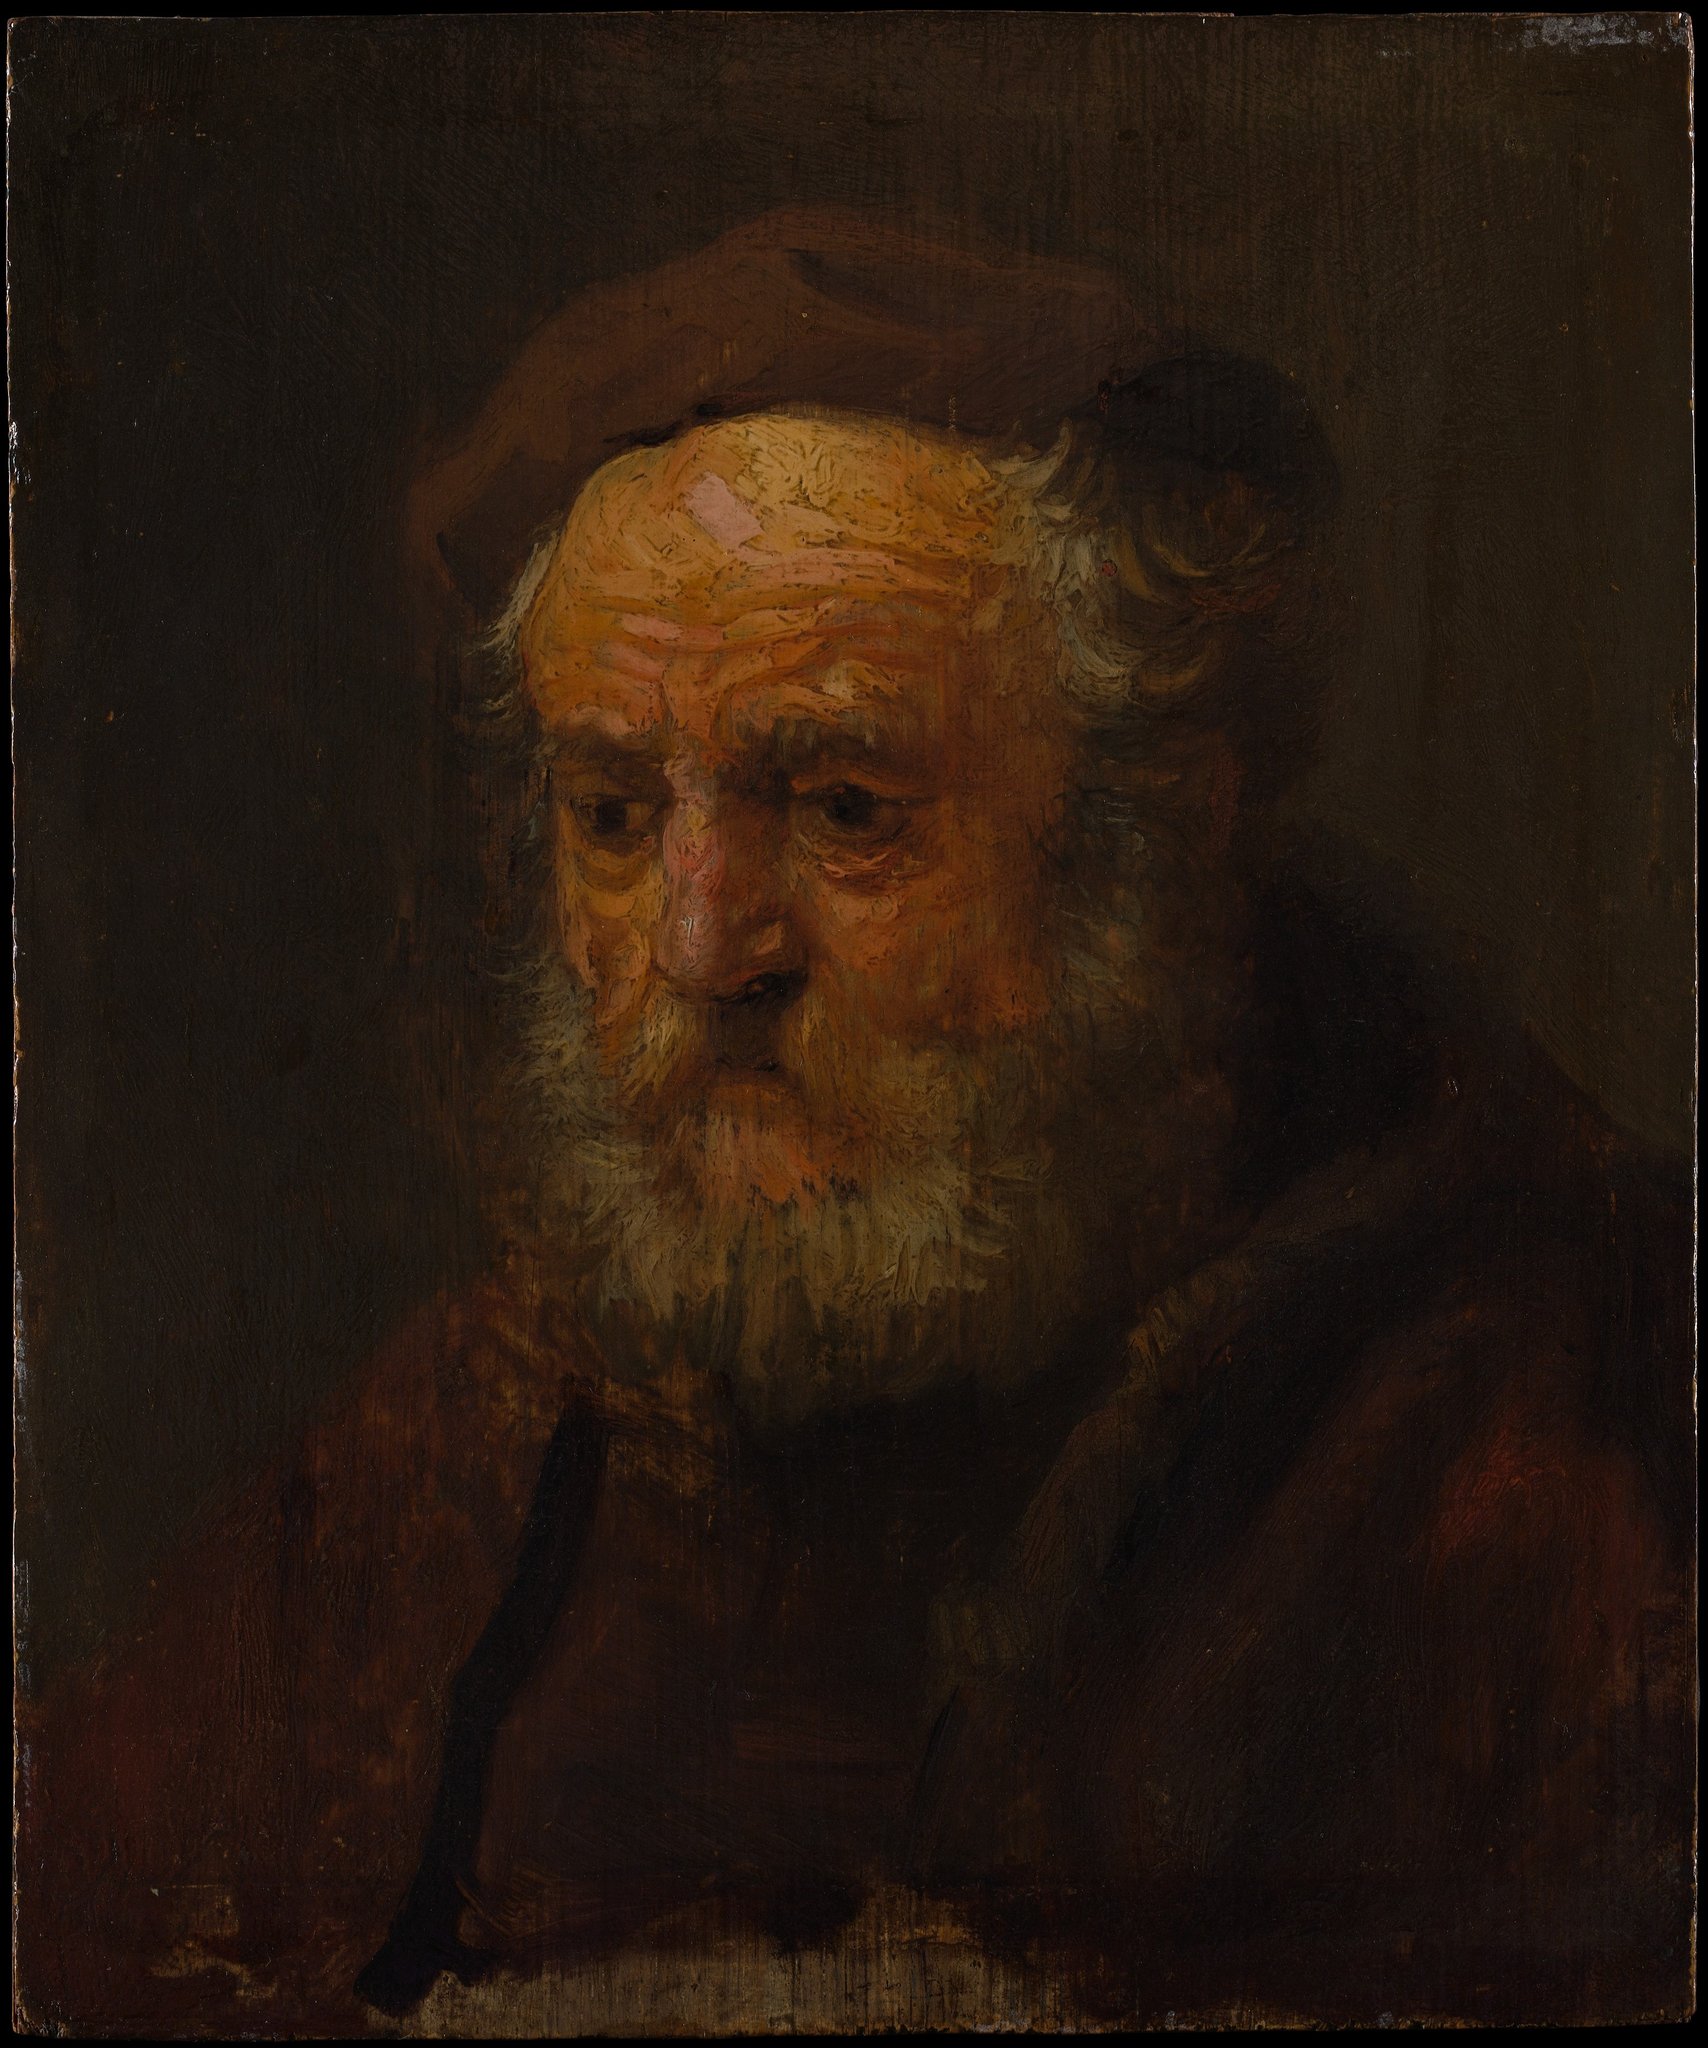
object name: painting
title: Study Head of an Old Man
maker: rembrandt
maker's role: artist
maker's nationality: dutch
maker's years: 1606-1669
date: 1600-1699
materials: oil, wood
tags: men,portraits